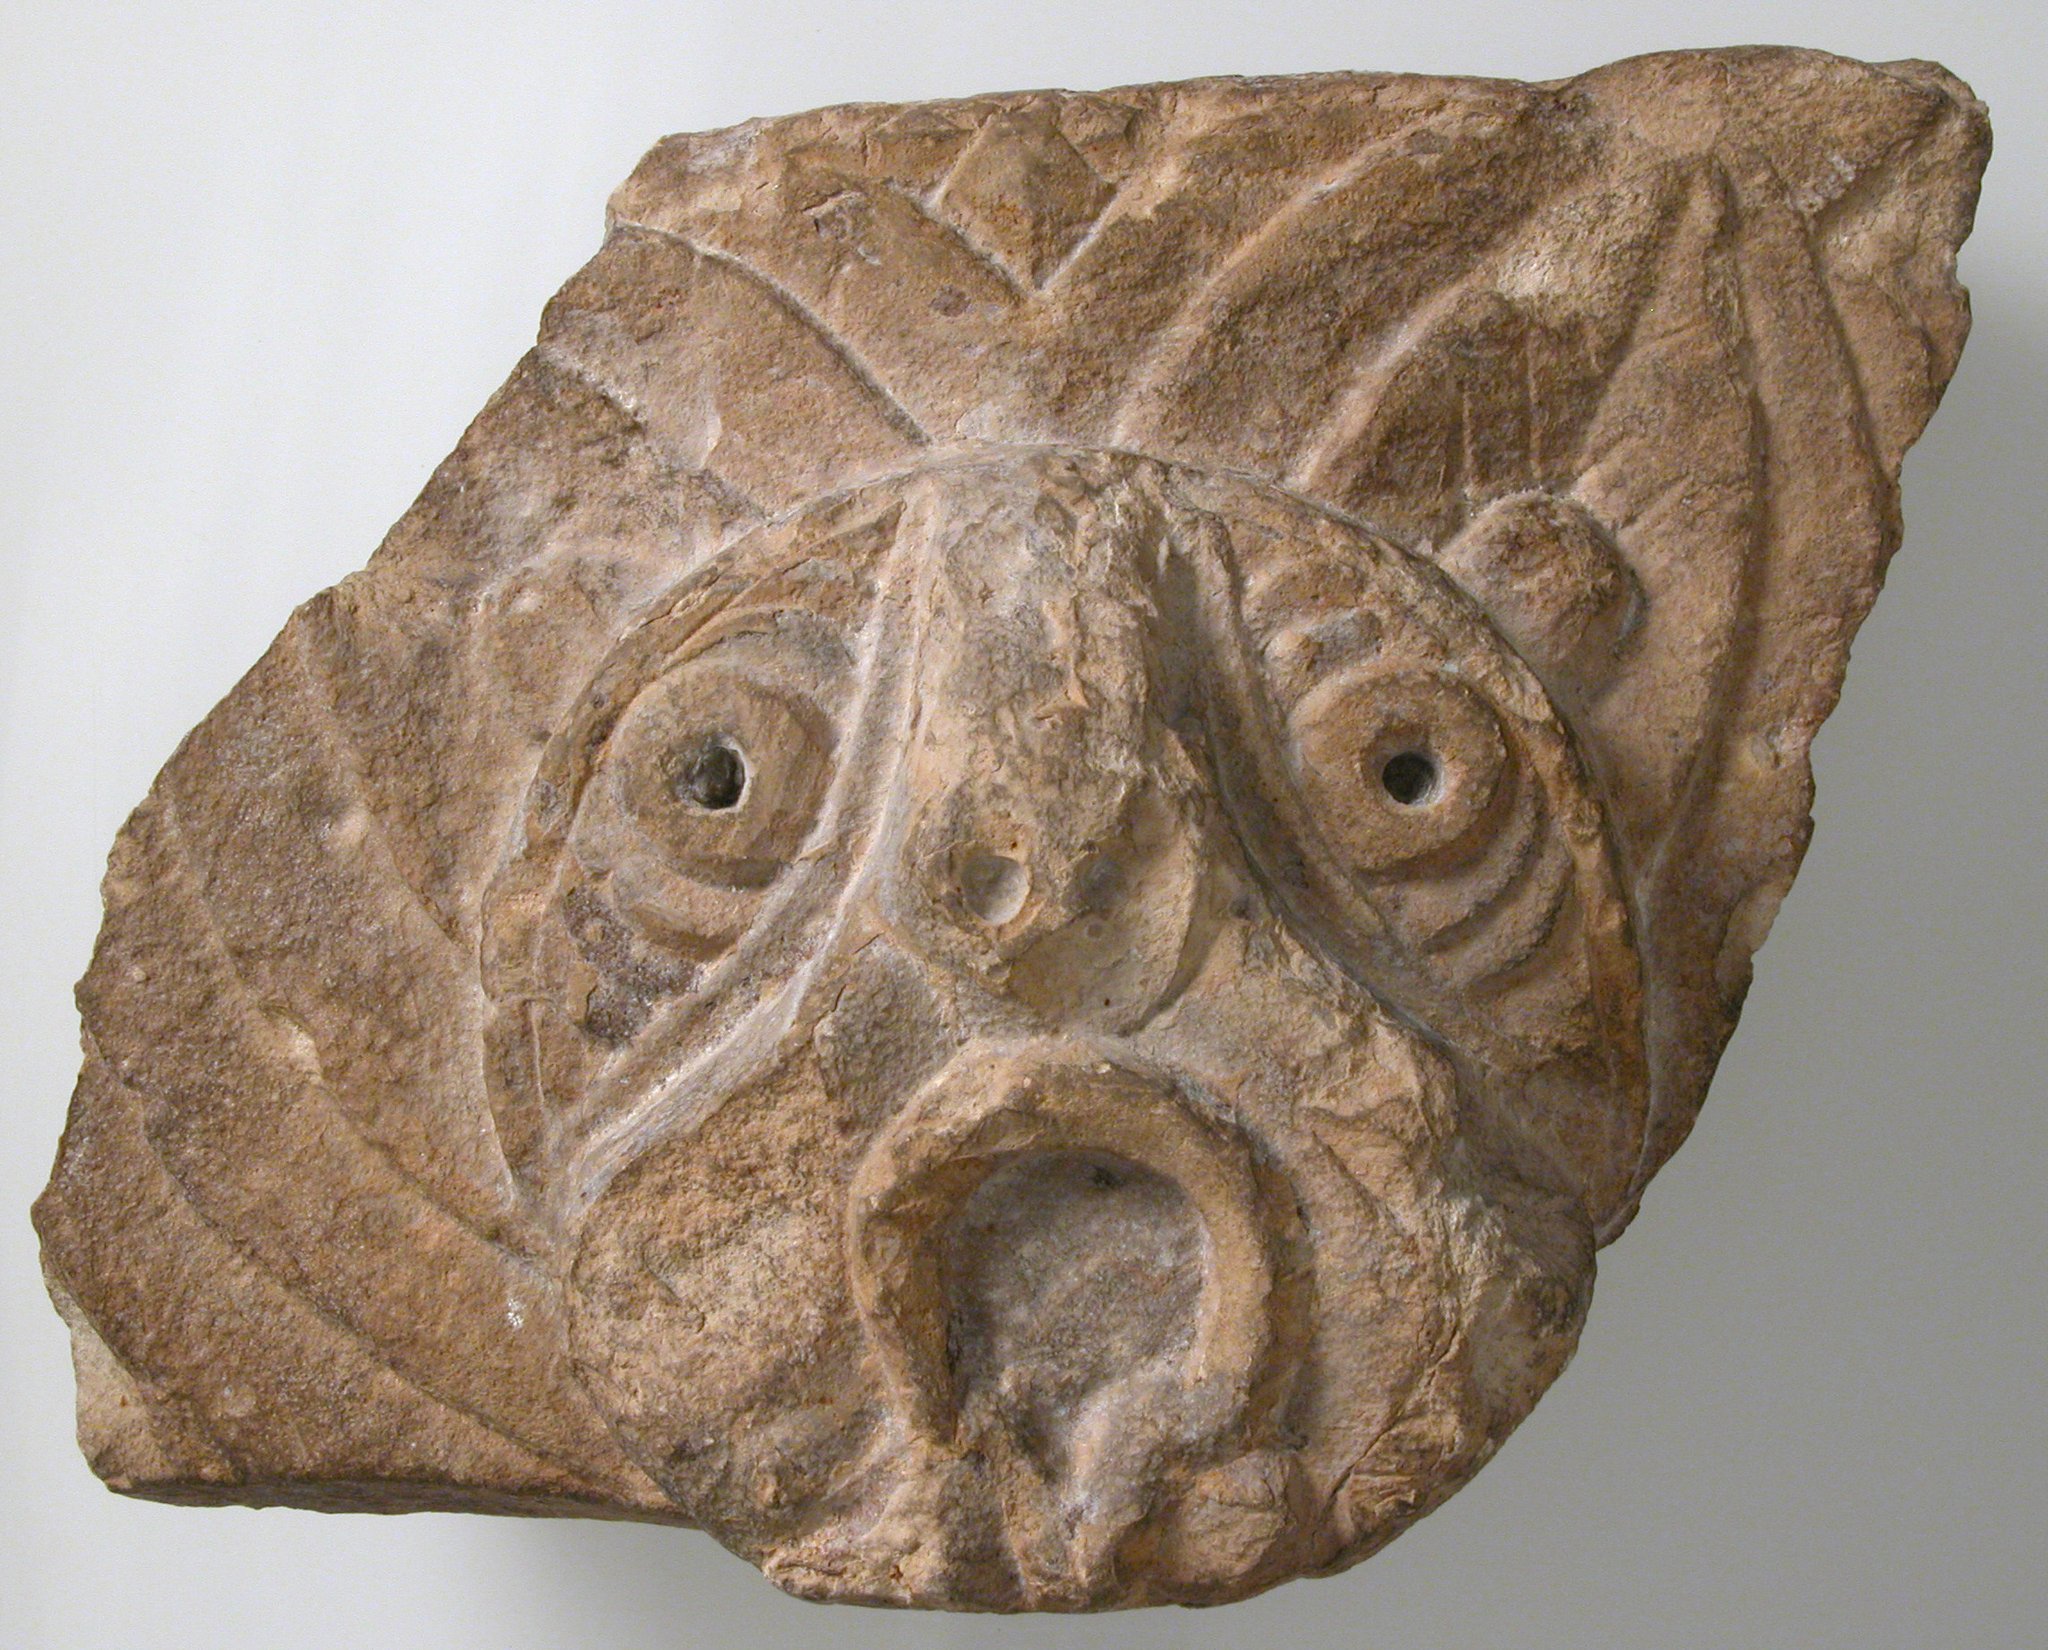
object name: cornice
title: Cornice Relief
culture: coptic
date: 301-700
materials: metal, stone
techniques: inlay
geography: egypt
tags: faces